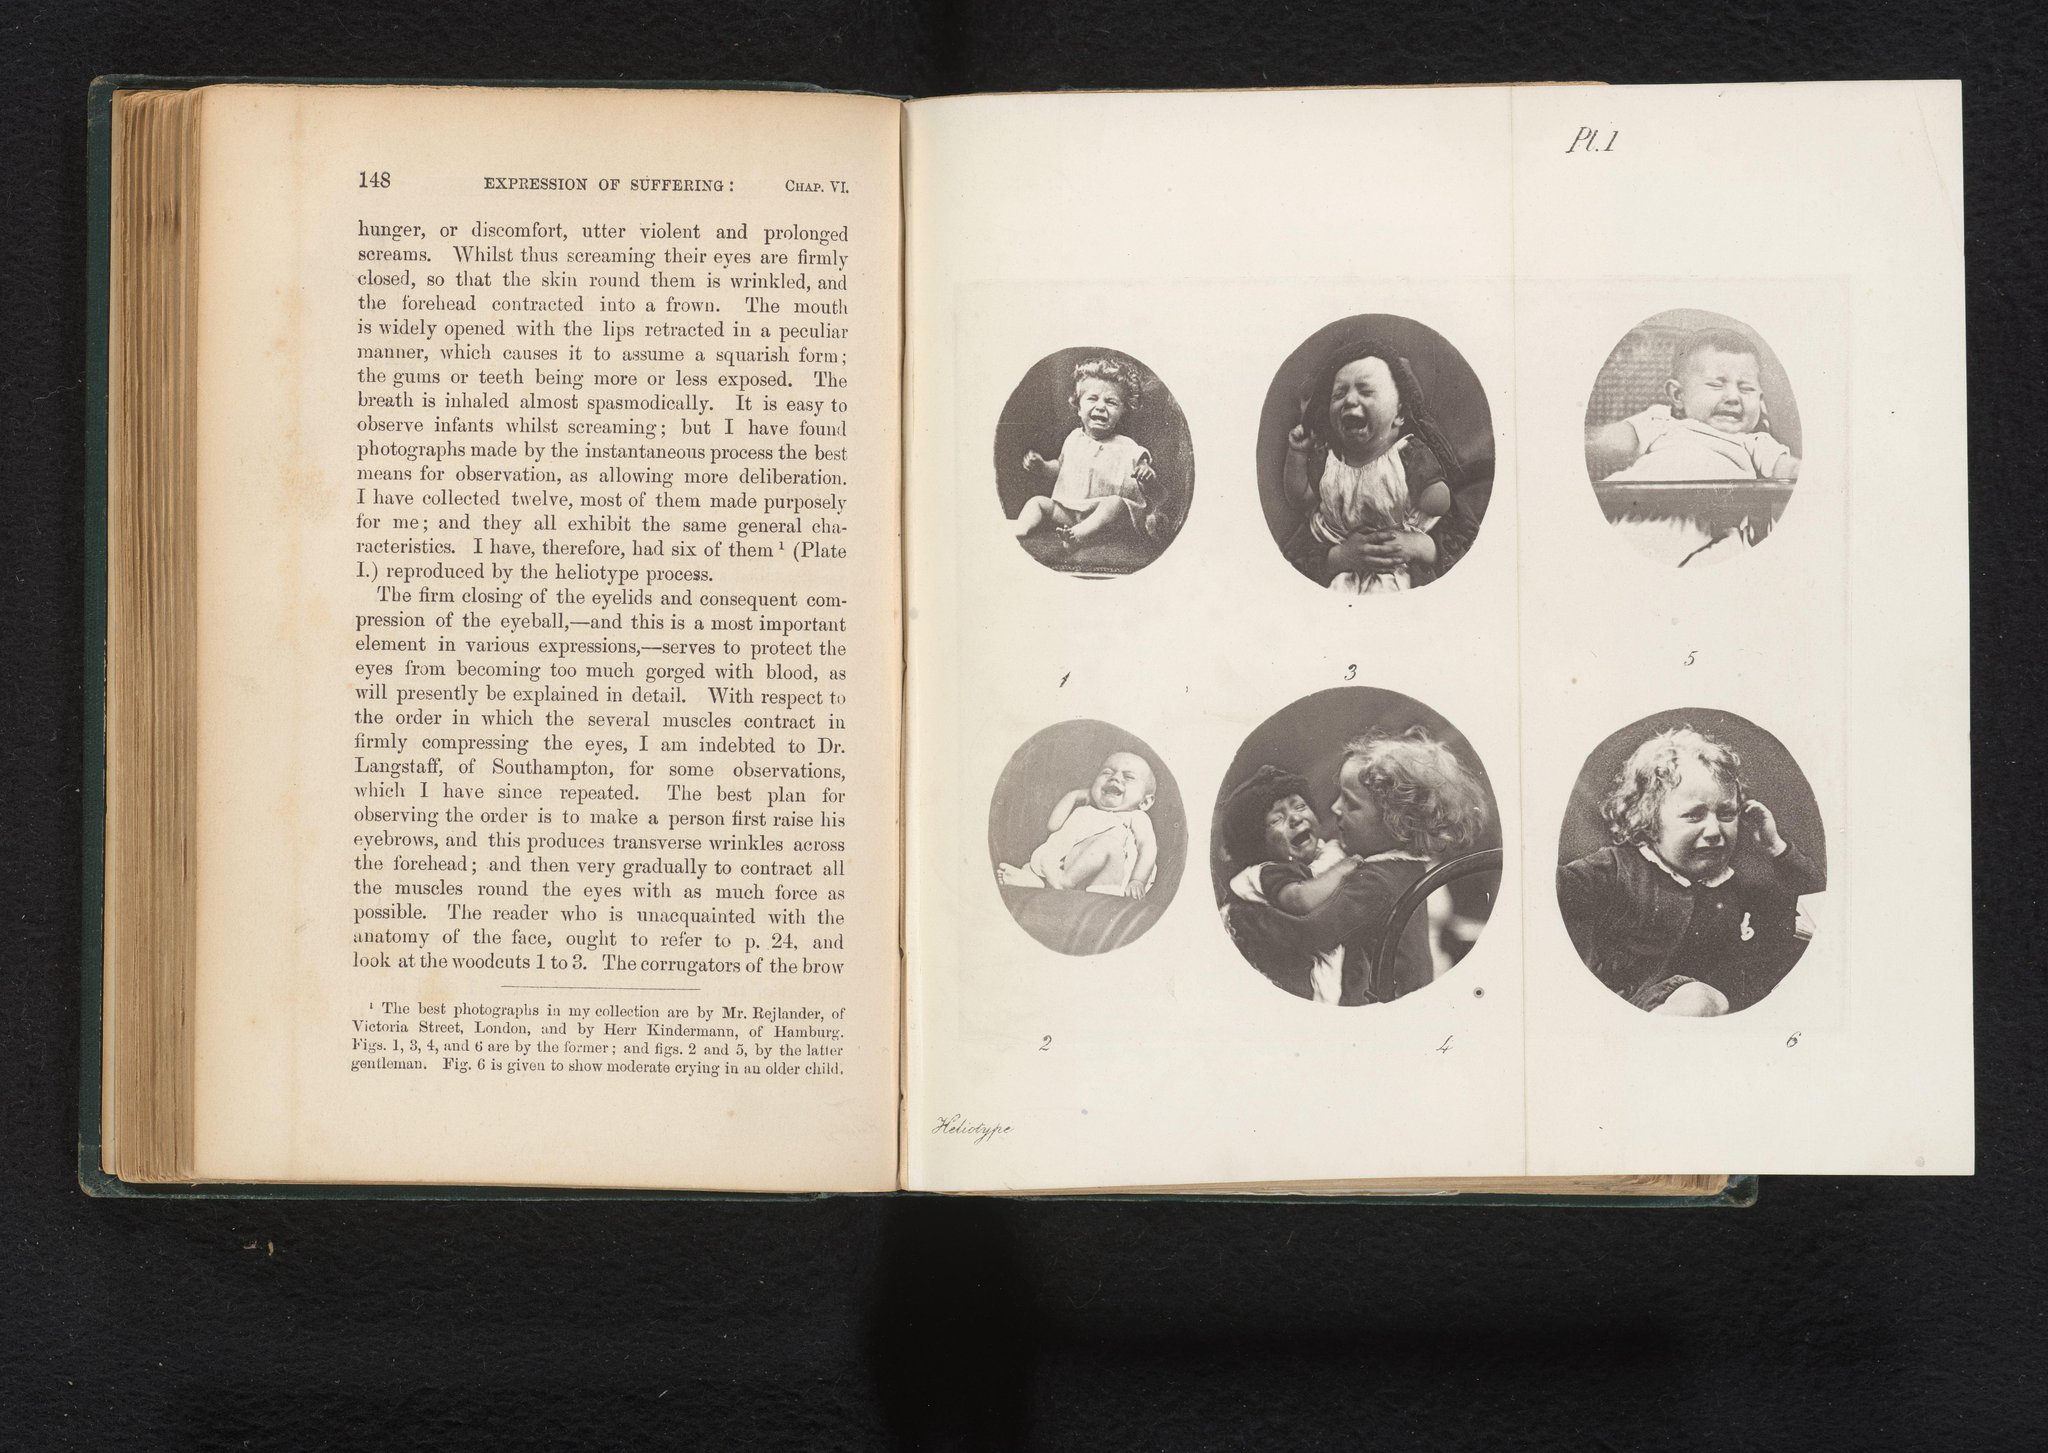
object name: photomechanical print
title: Overzicht van zes foto's ter illustratie van huilende baby's en kinderen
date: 1867-1872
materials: paper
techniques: photoaquatint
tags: child, morphology of facial expression, crying, shouting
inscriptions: inscription: ‘Pl.1’